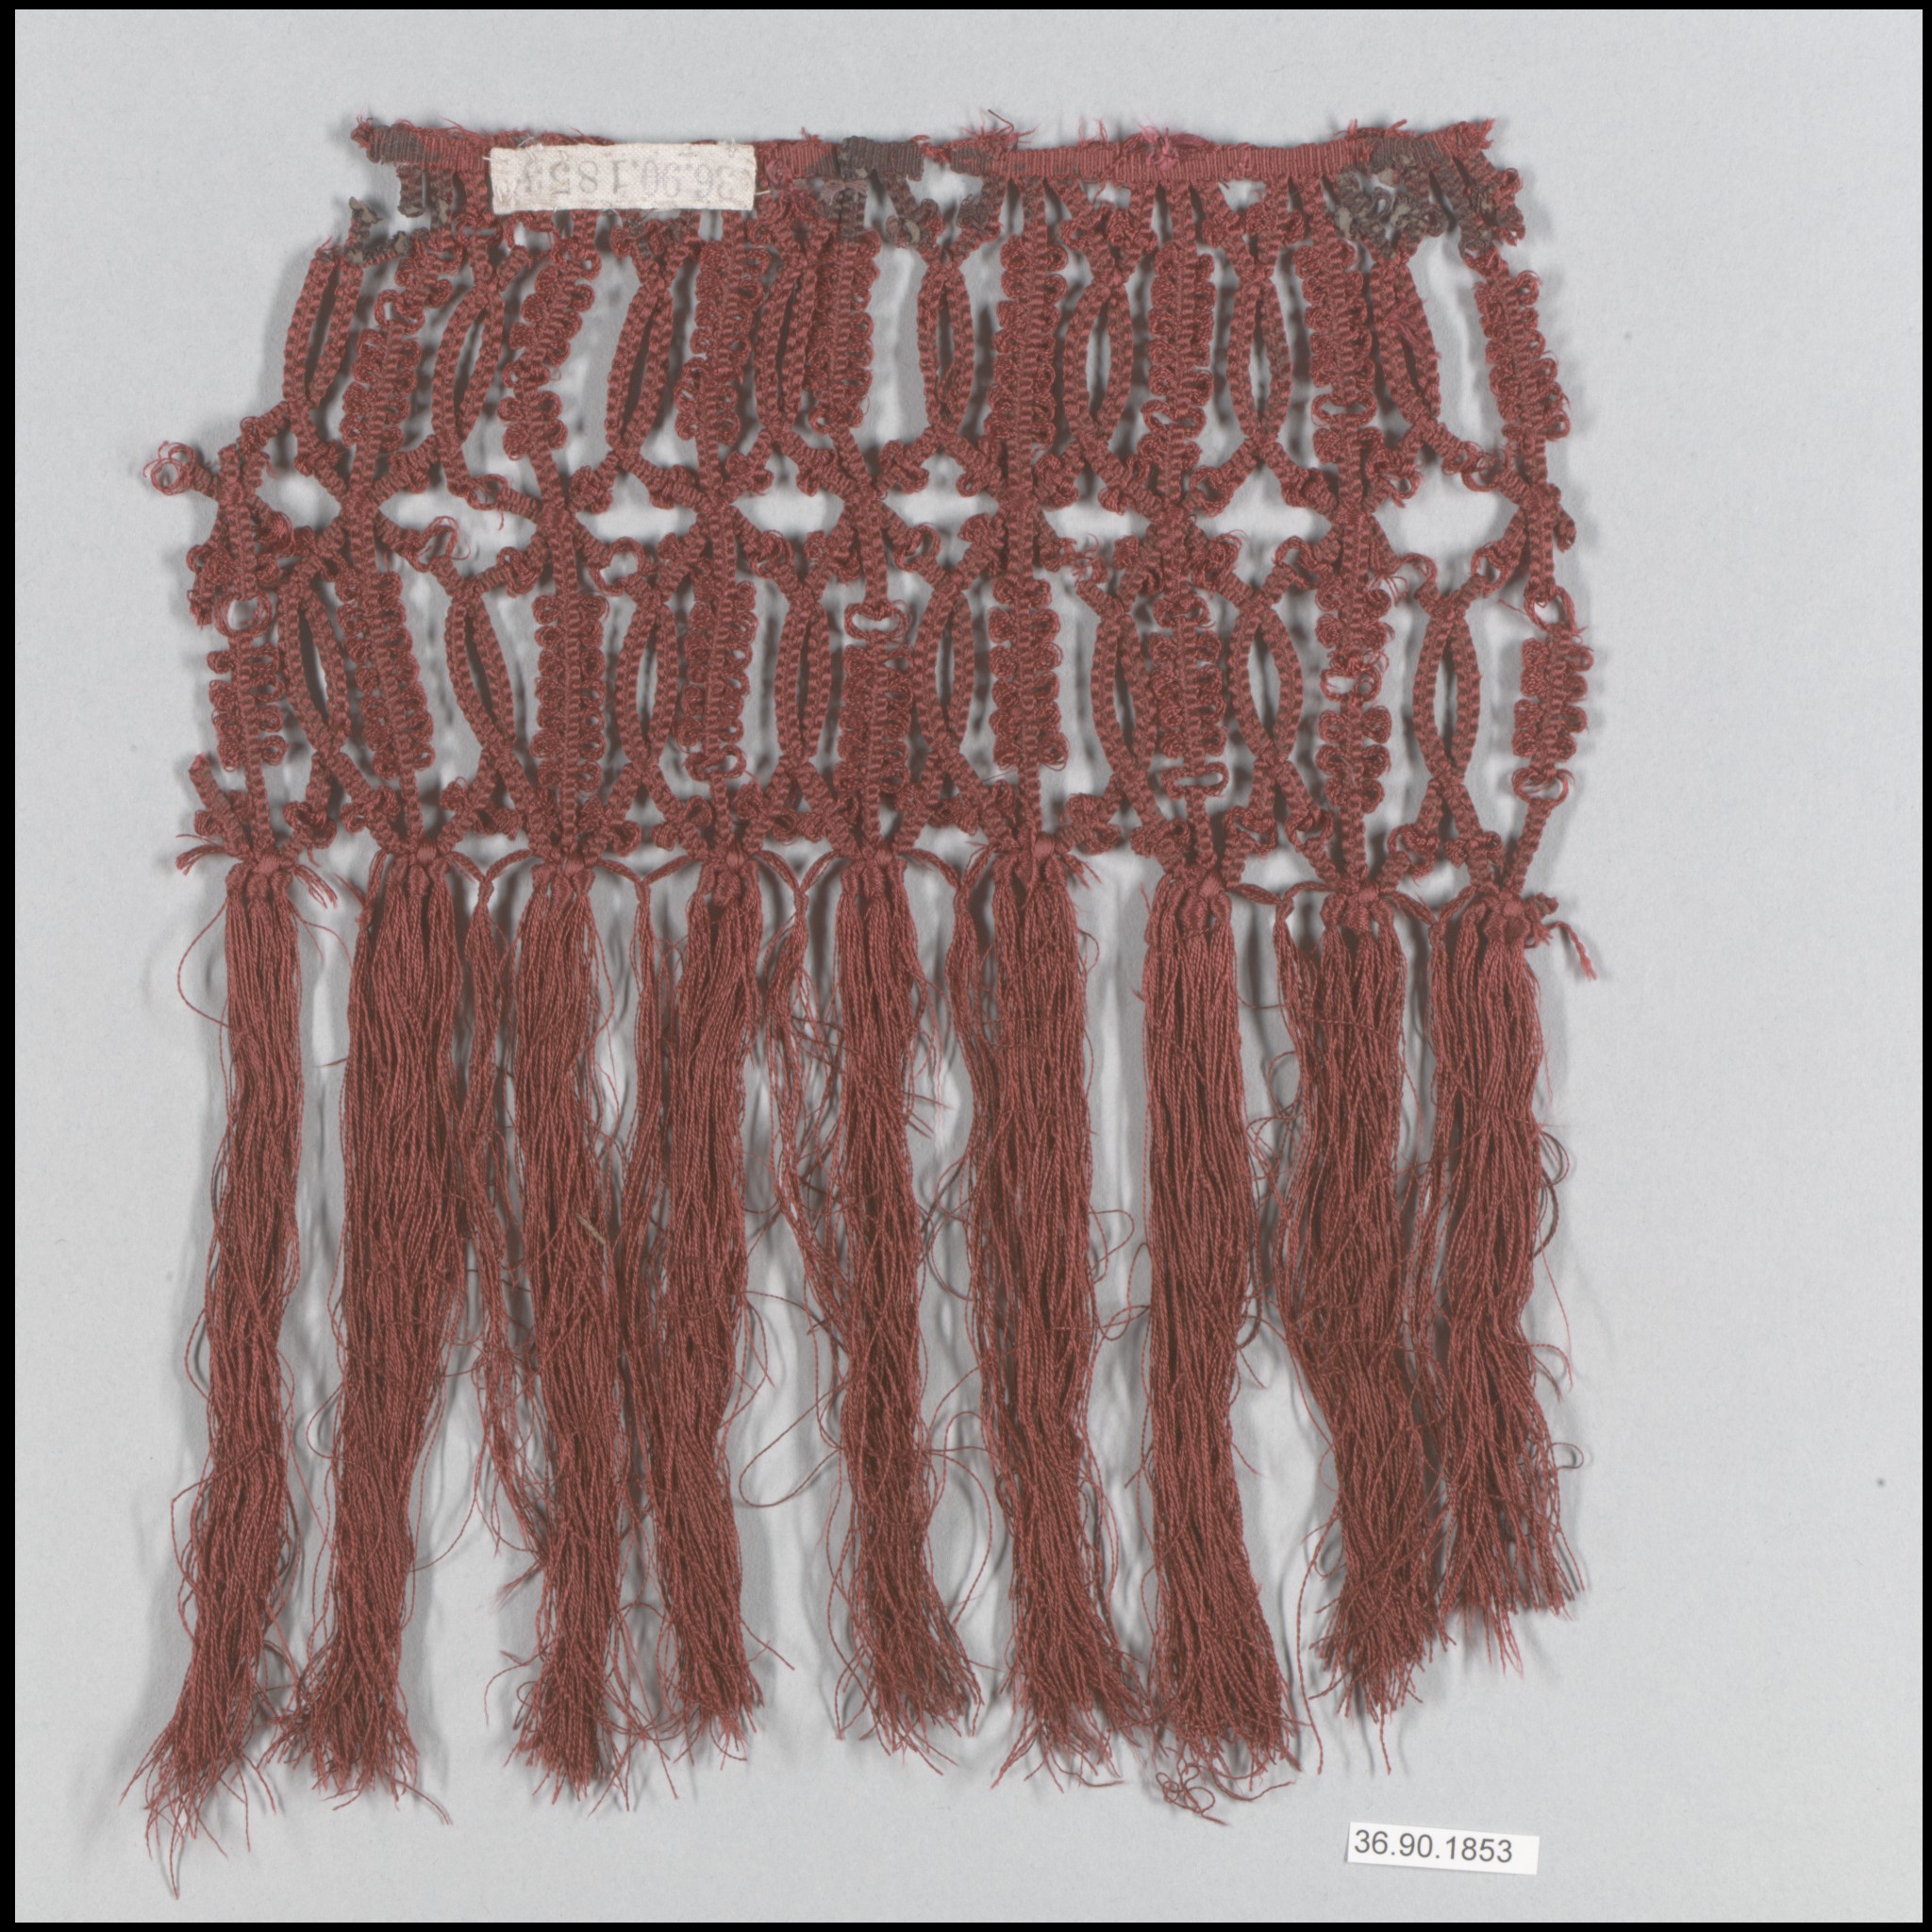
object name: fringe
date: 1801-1833